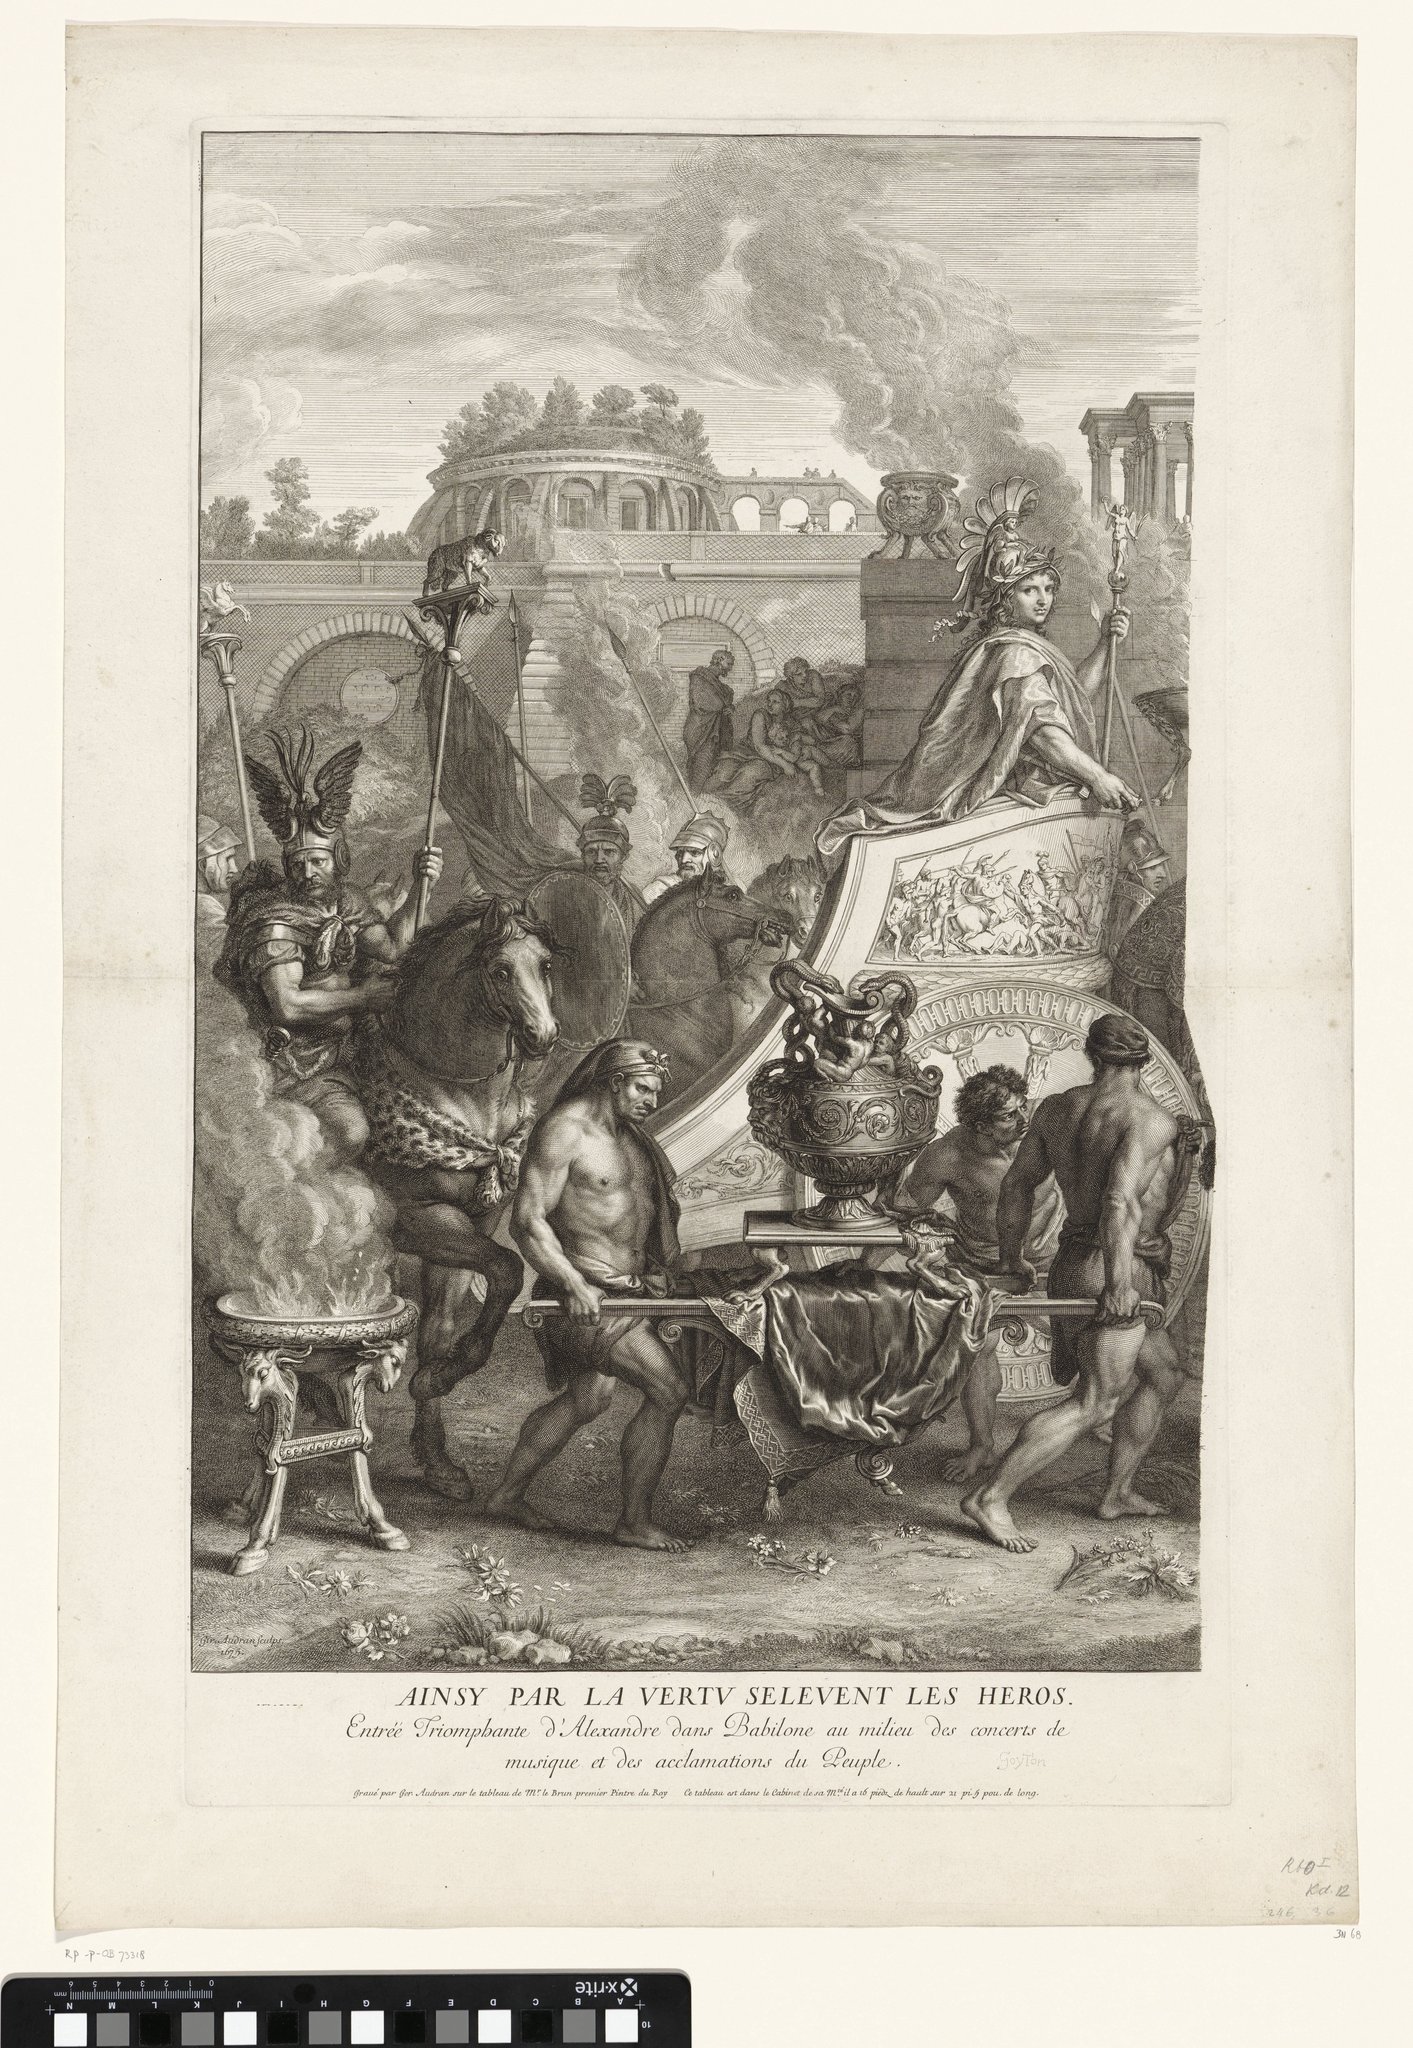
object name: print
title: Alexander de Grote trekt Babylon binnen (linkerblad)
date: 1675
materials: paper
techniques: engraving, etching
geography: paris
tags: alexander's triumphal entry into babylon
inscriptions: inscription: ‘246, 36’, inscription: ‘R[...]OI’, inscription: ‘Kd. 14’, collector's mark: Lugt 1838, collector's mark: Lugt 240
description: Linkerblad van een prent gedrukt van twee platen.